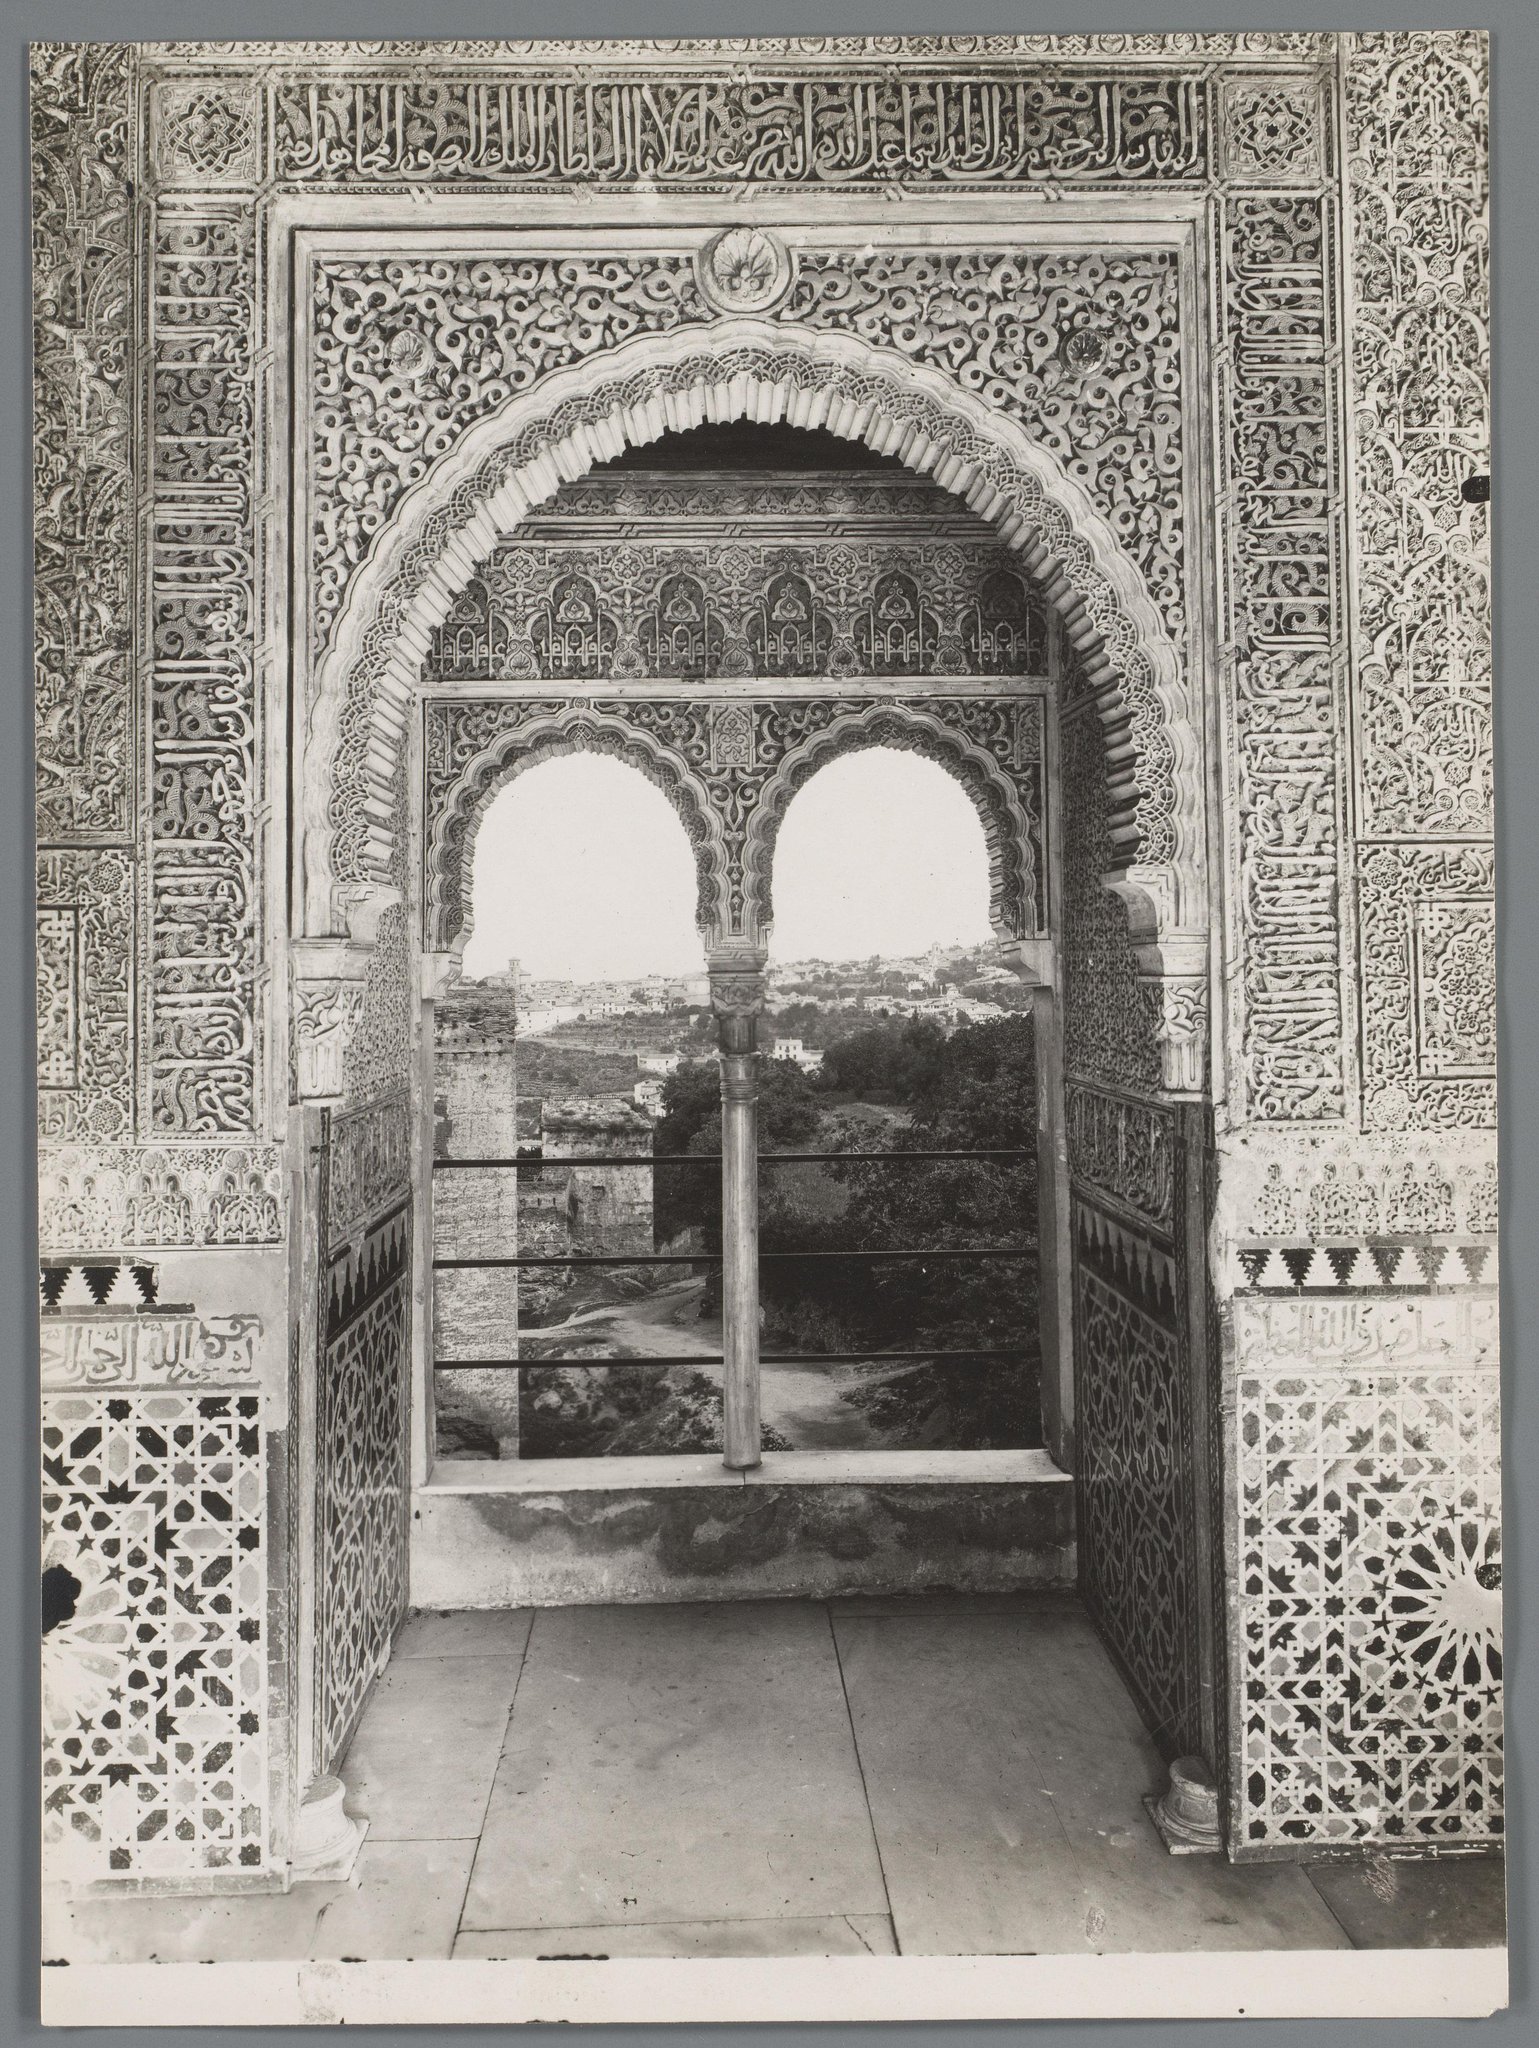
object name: photograph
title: Uitzicht op de omgeving vanuit het Alhambra in Granada, Spanje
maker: f. linares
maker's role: publisher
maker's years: 1870-1937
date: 1837-1914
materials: photographic support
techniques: gelatin silver print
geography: alhambra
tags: palace, stuccoeing